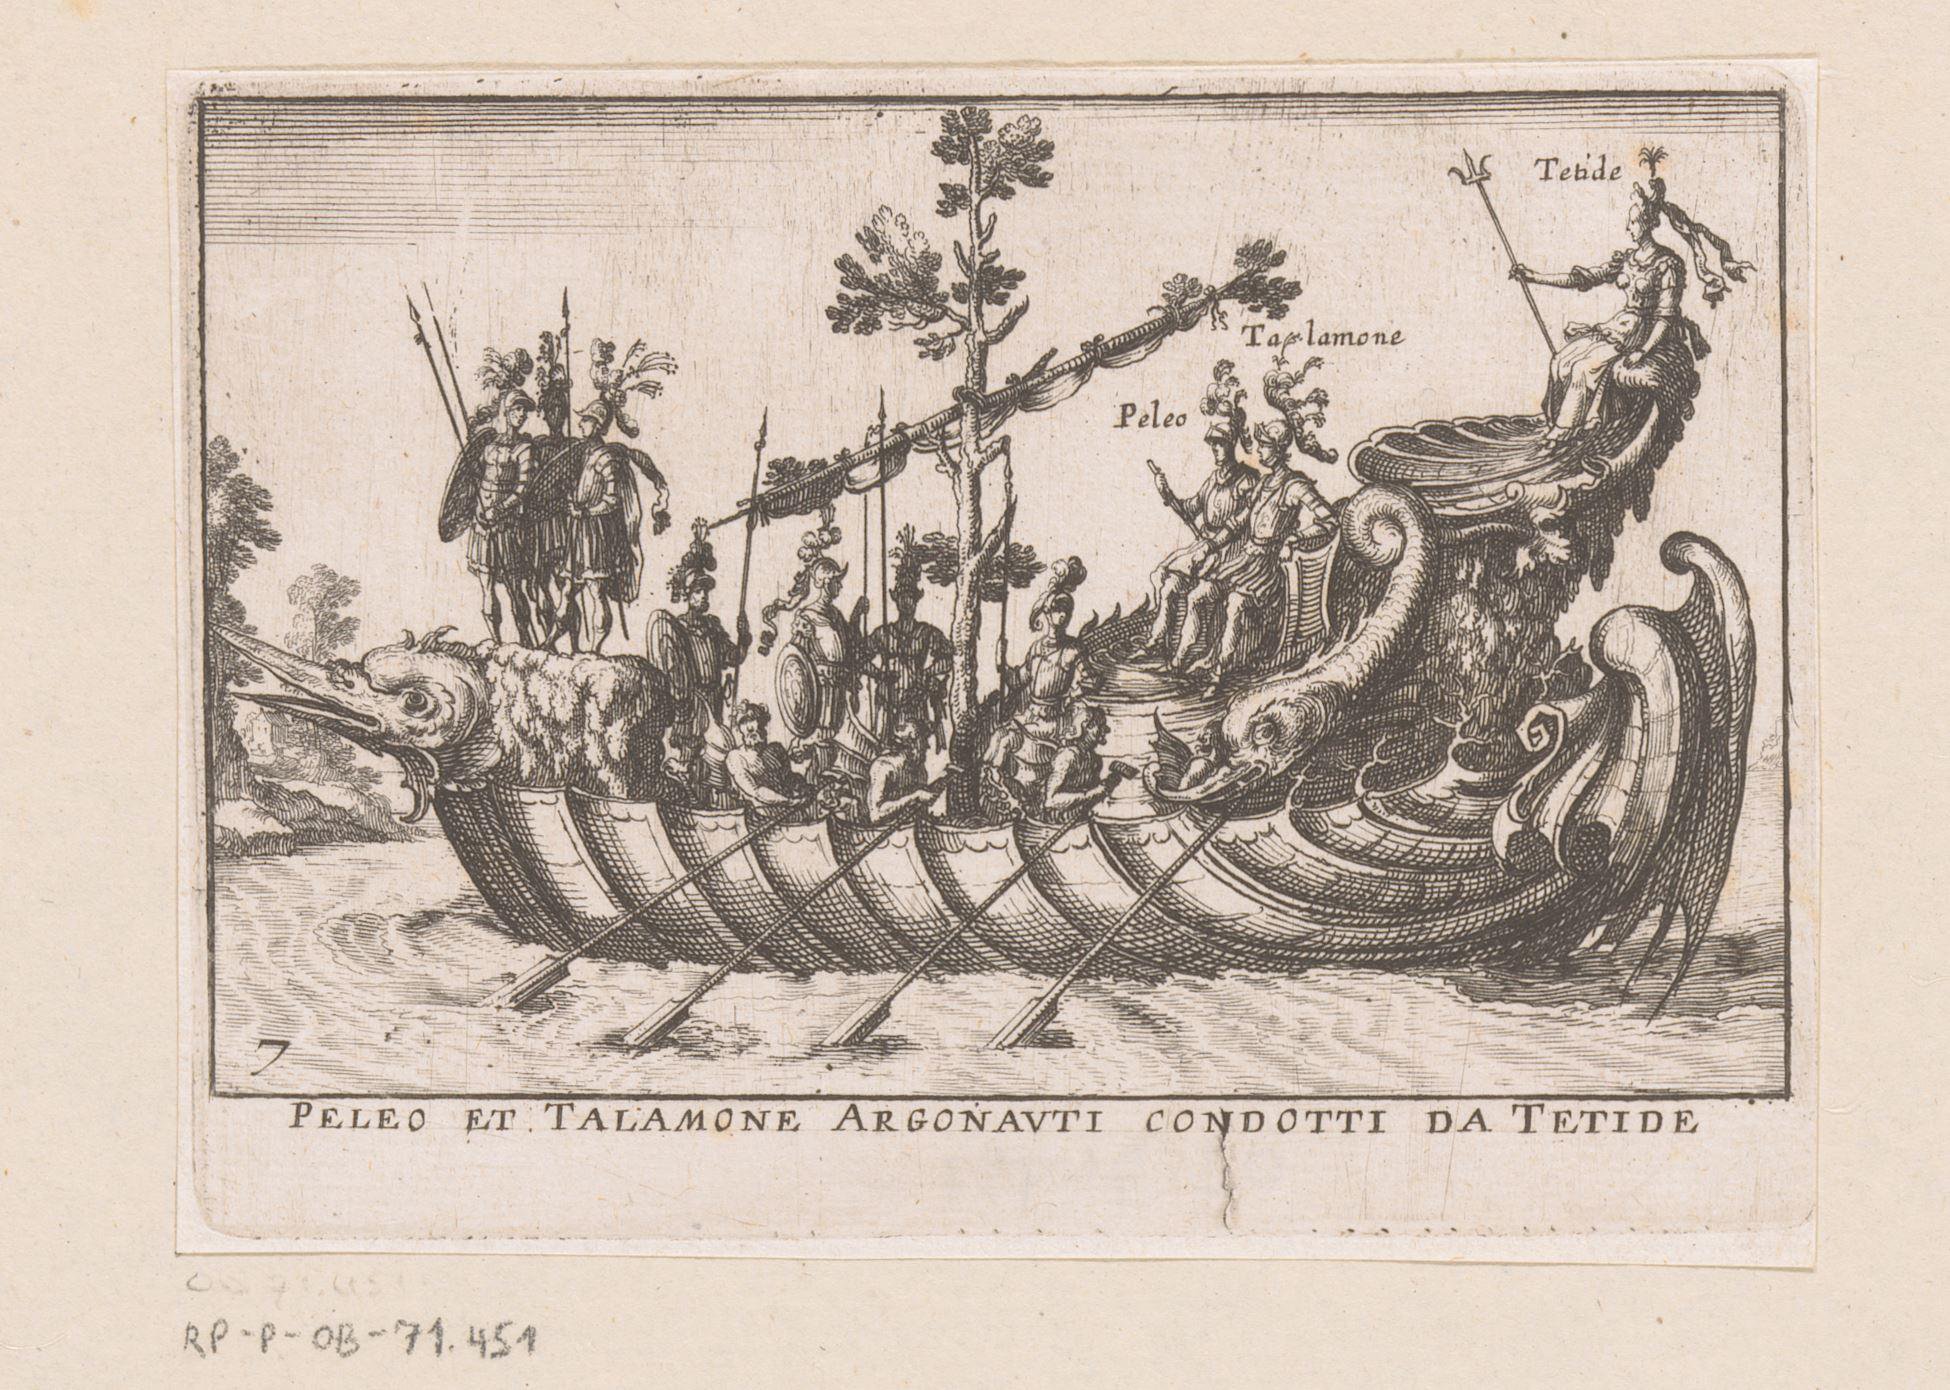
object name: print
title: Le Magnifique Carousel fait sur le fleuve de l'Arne à Florence pour le mariage du grand Duc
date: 1635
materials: paper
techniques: etching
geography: paris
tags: ships (in general), the story of the argonauts: the quest for the golden fleece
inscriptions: collector's mark: Lugt 240